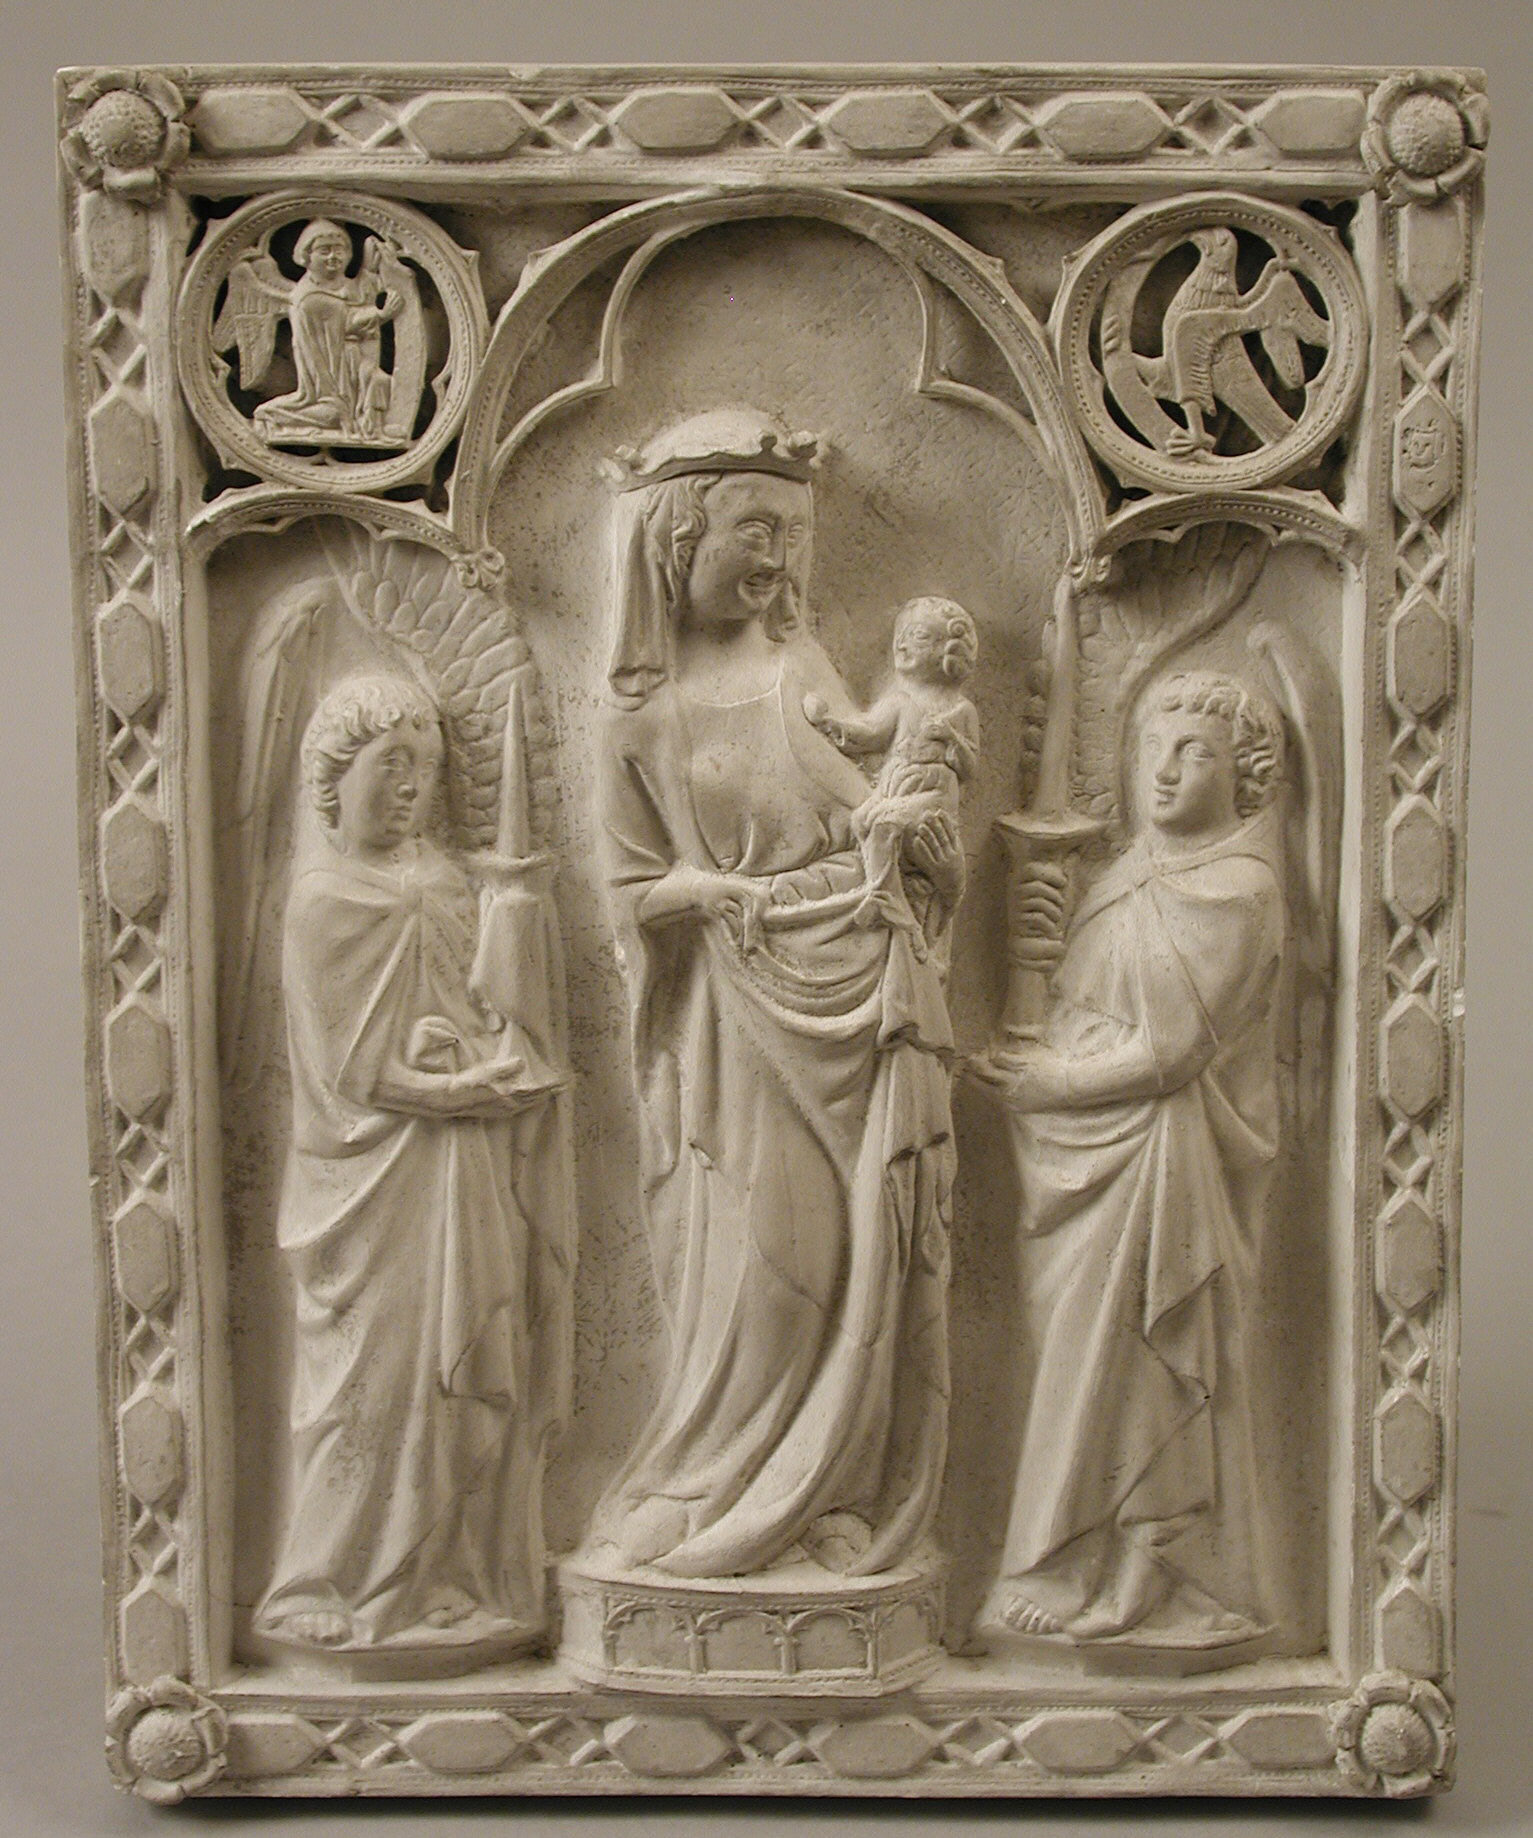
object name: book cover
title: Book-Cover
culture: french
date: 1401-1500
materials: plaster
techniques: casting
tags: angels,madonna and child